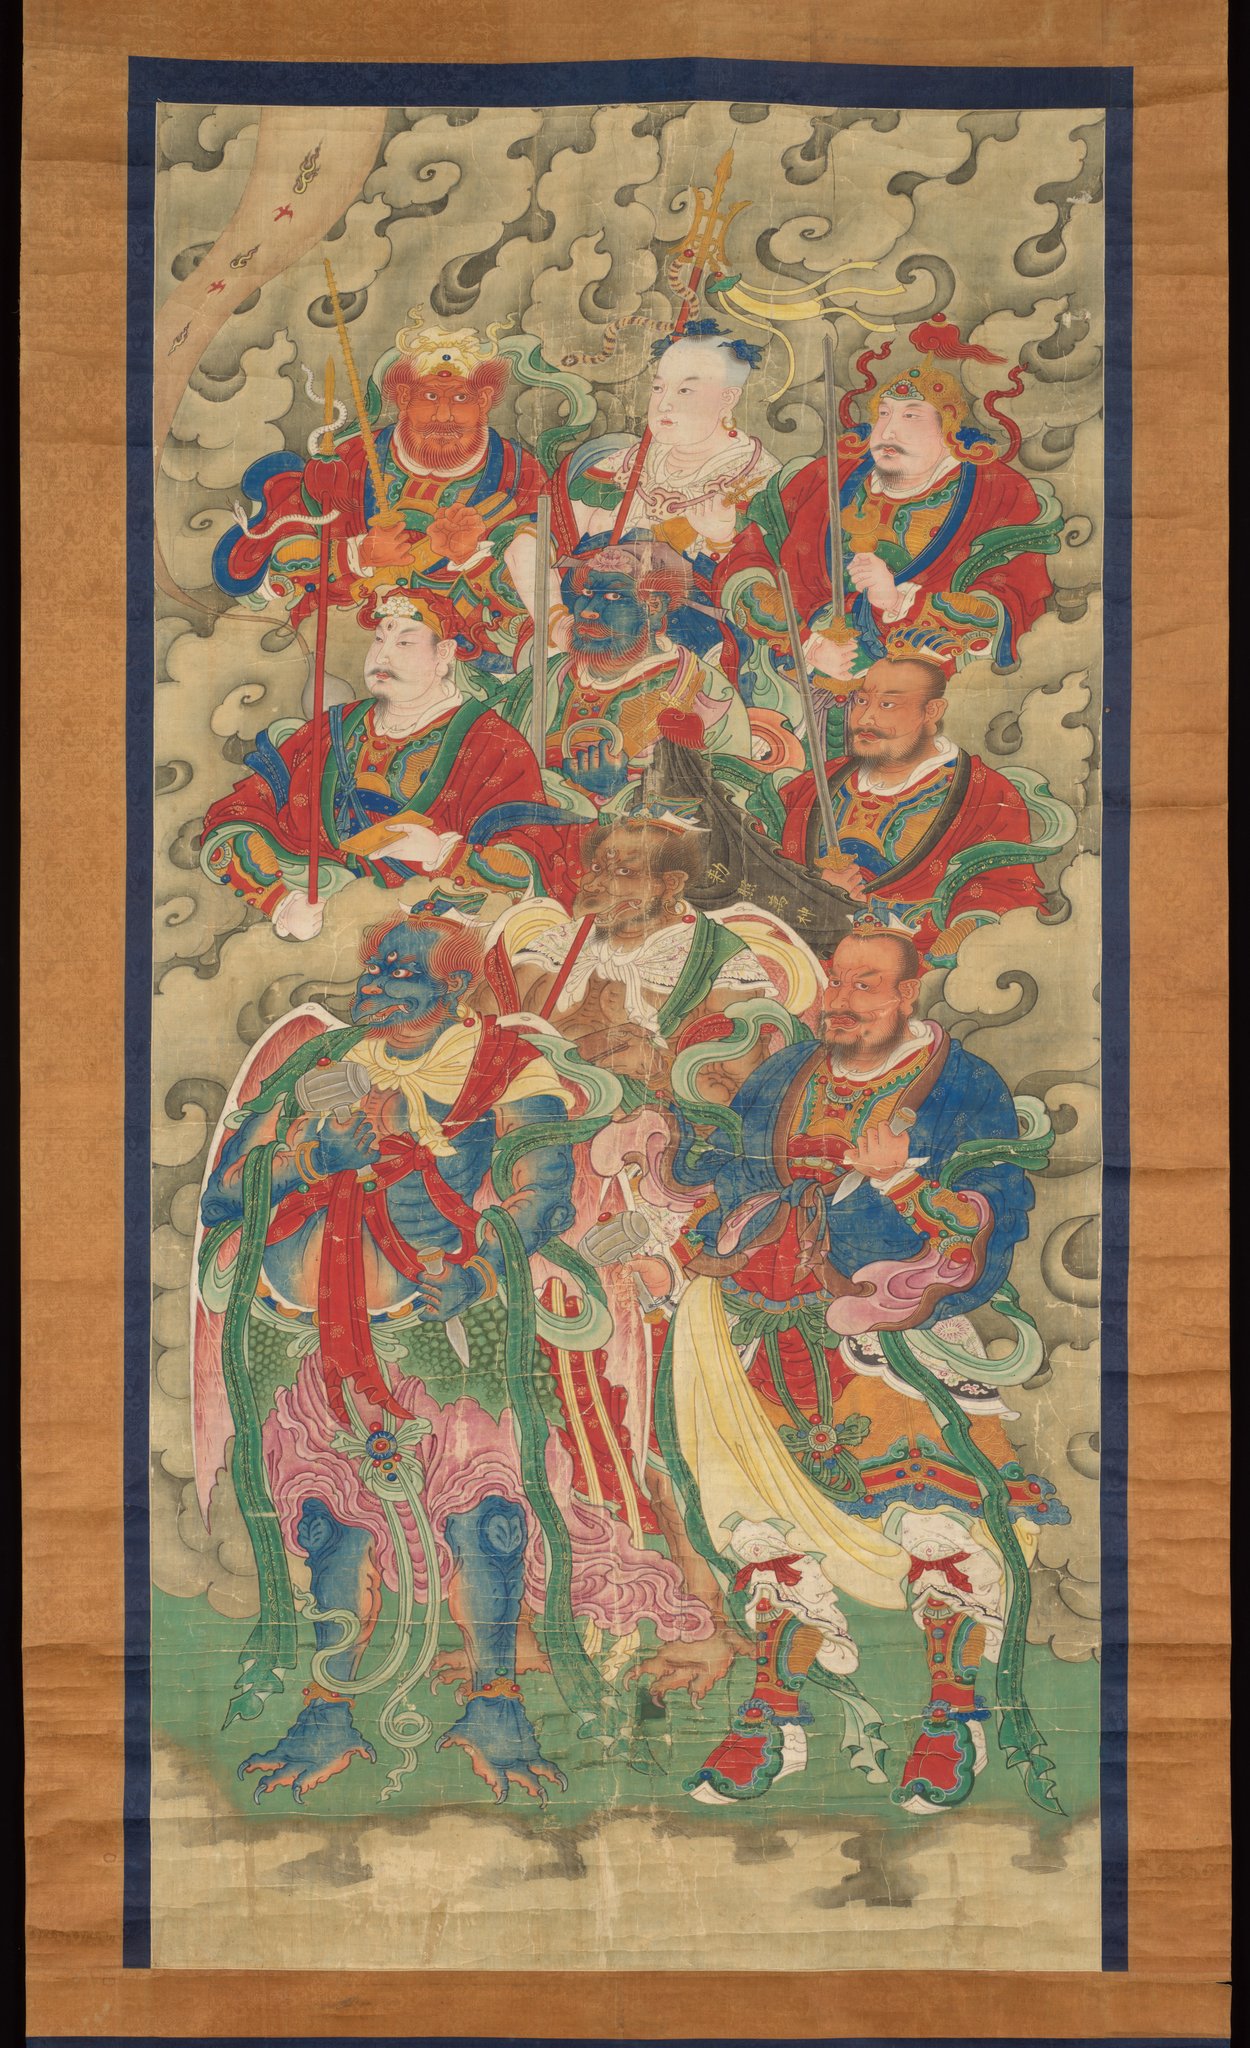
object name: hanging scroll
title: Nine Guardian Kings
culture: chinese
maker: unidentified artist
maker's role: artist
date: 1368-1644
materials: ink, paper